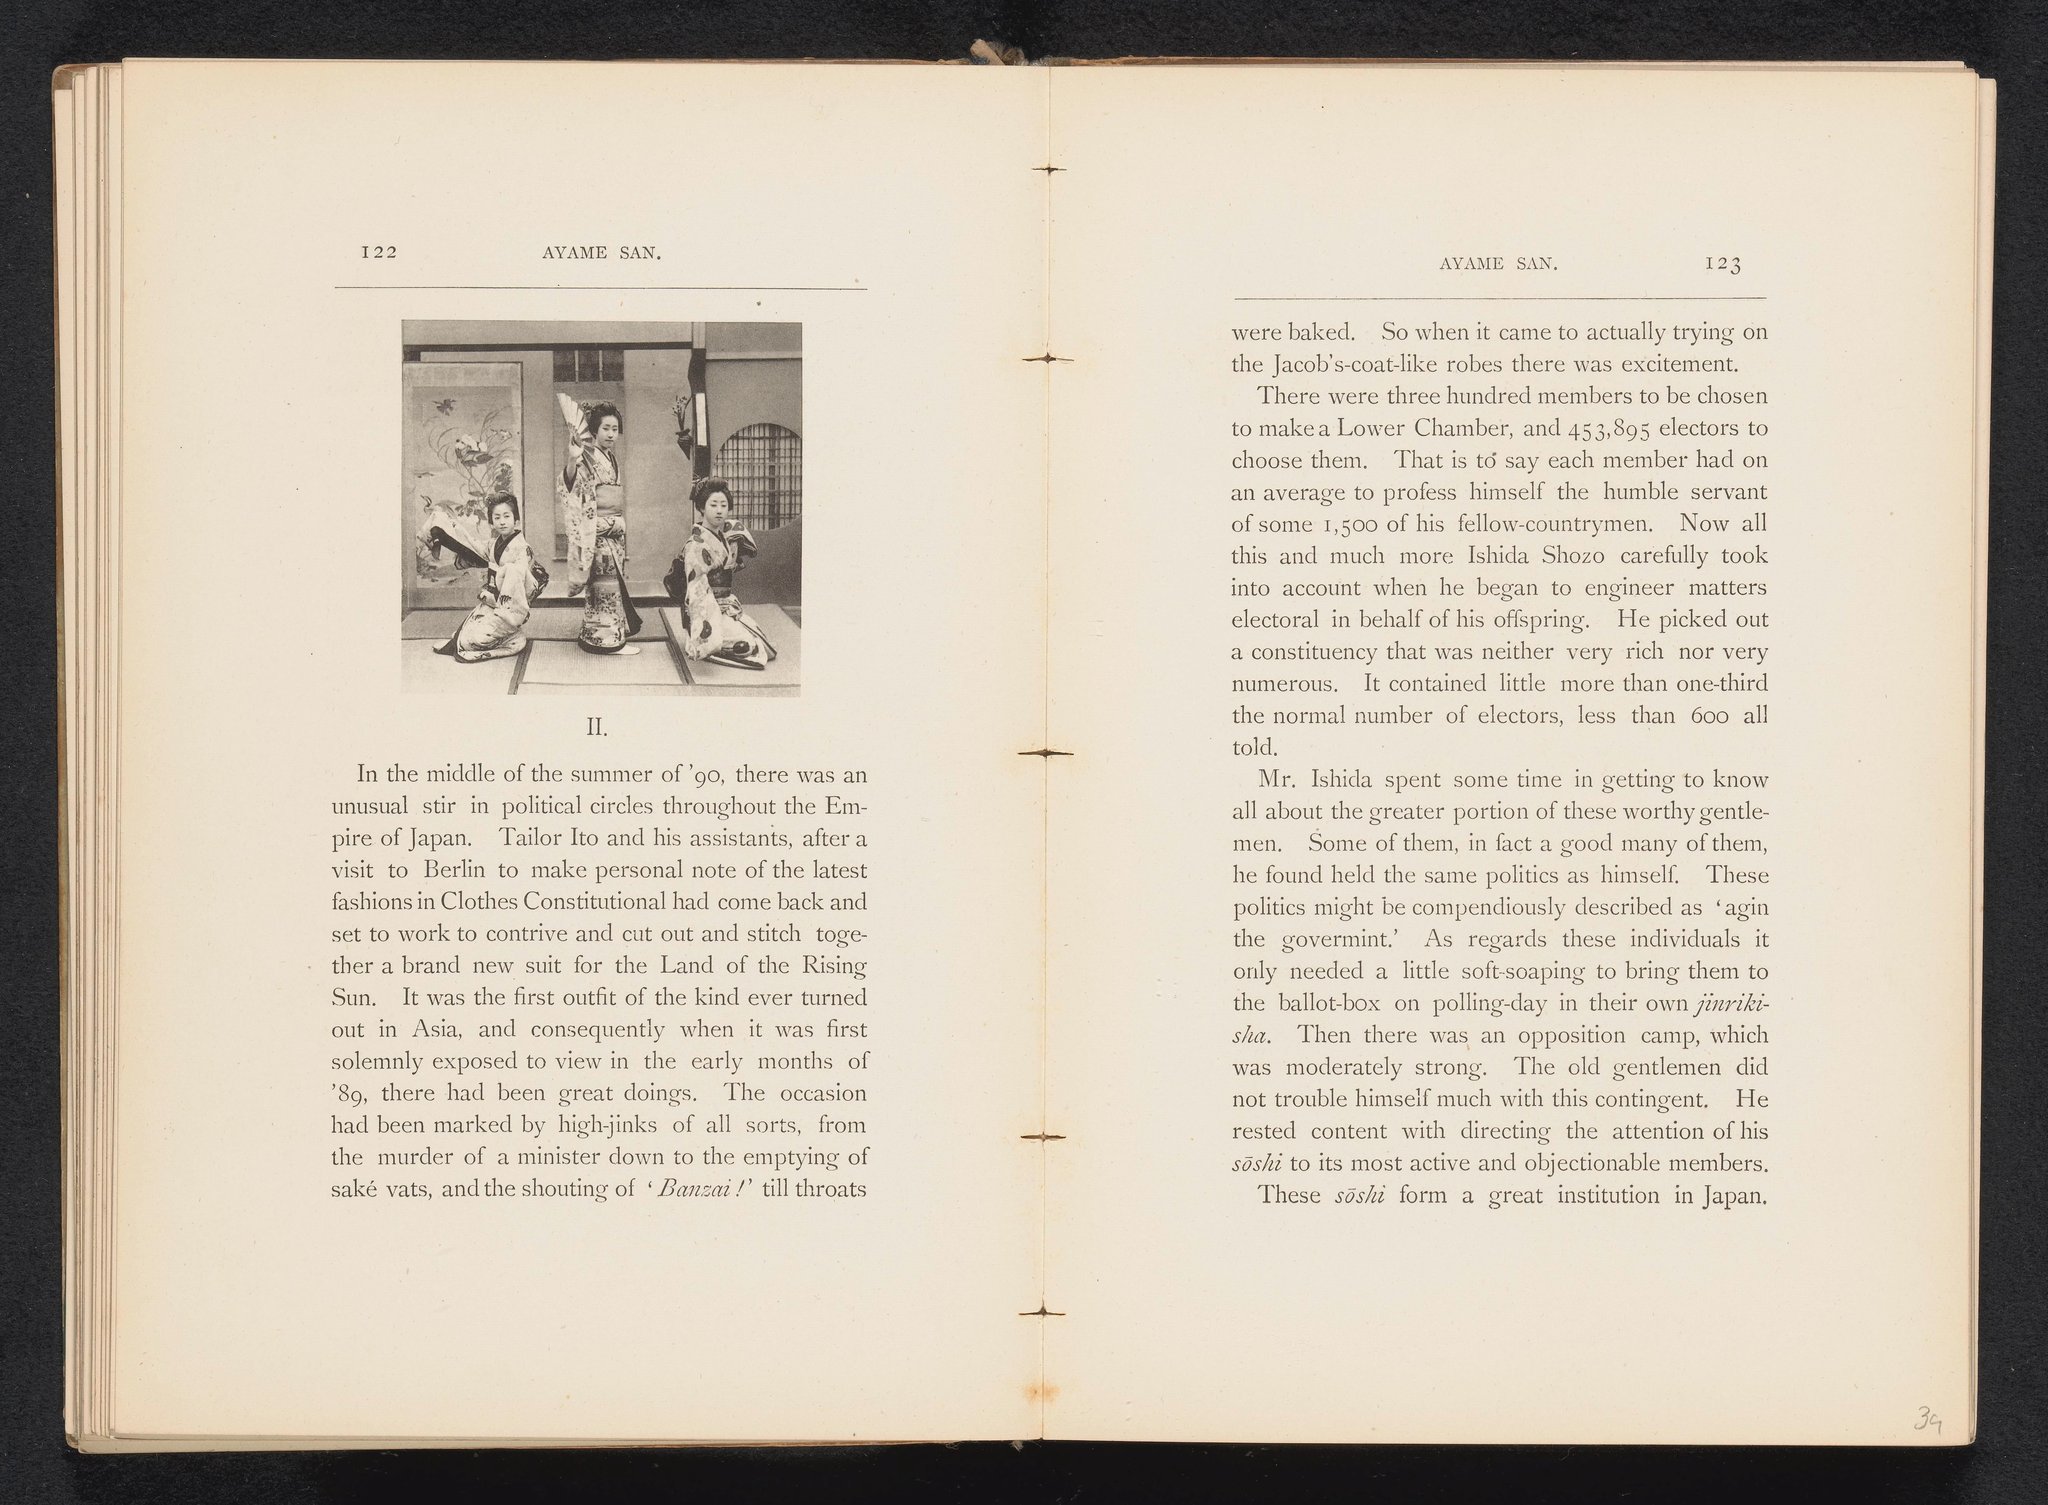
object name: page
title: Drie dansende vrouwen in een interieur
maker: kazumasa ogawa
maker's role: auteur, fotograaf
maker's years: 1860-1929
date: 1882-1892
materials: paper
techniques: photograph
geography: japan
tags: group dancing, interior ~ representation of a building